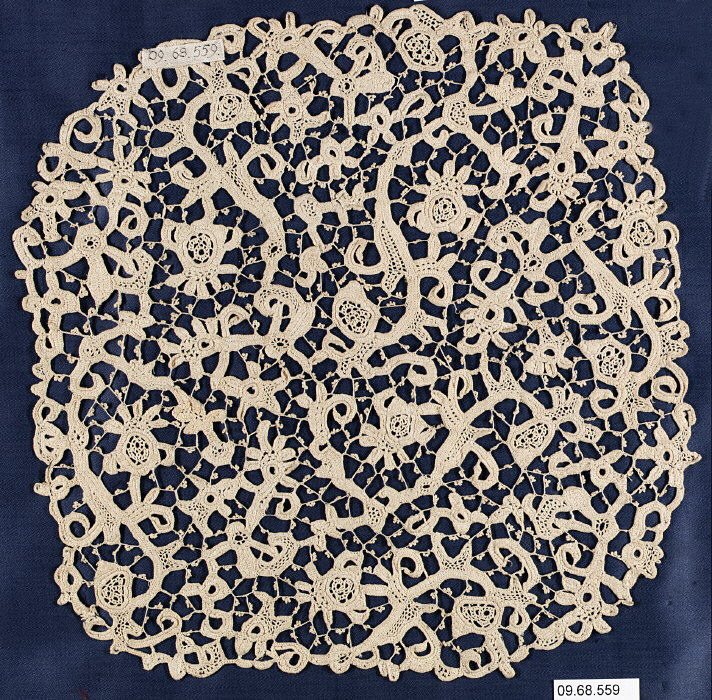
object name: cap crown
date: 1801-1900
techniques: crochet